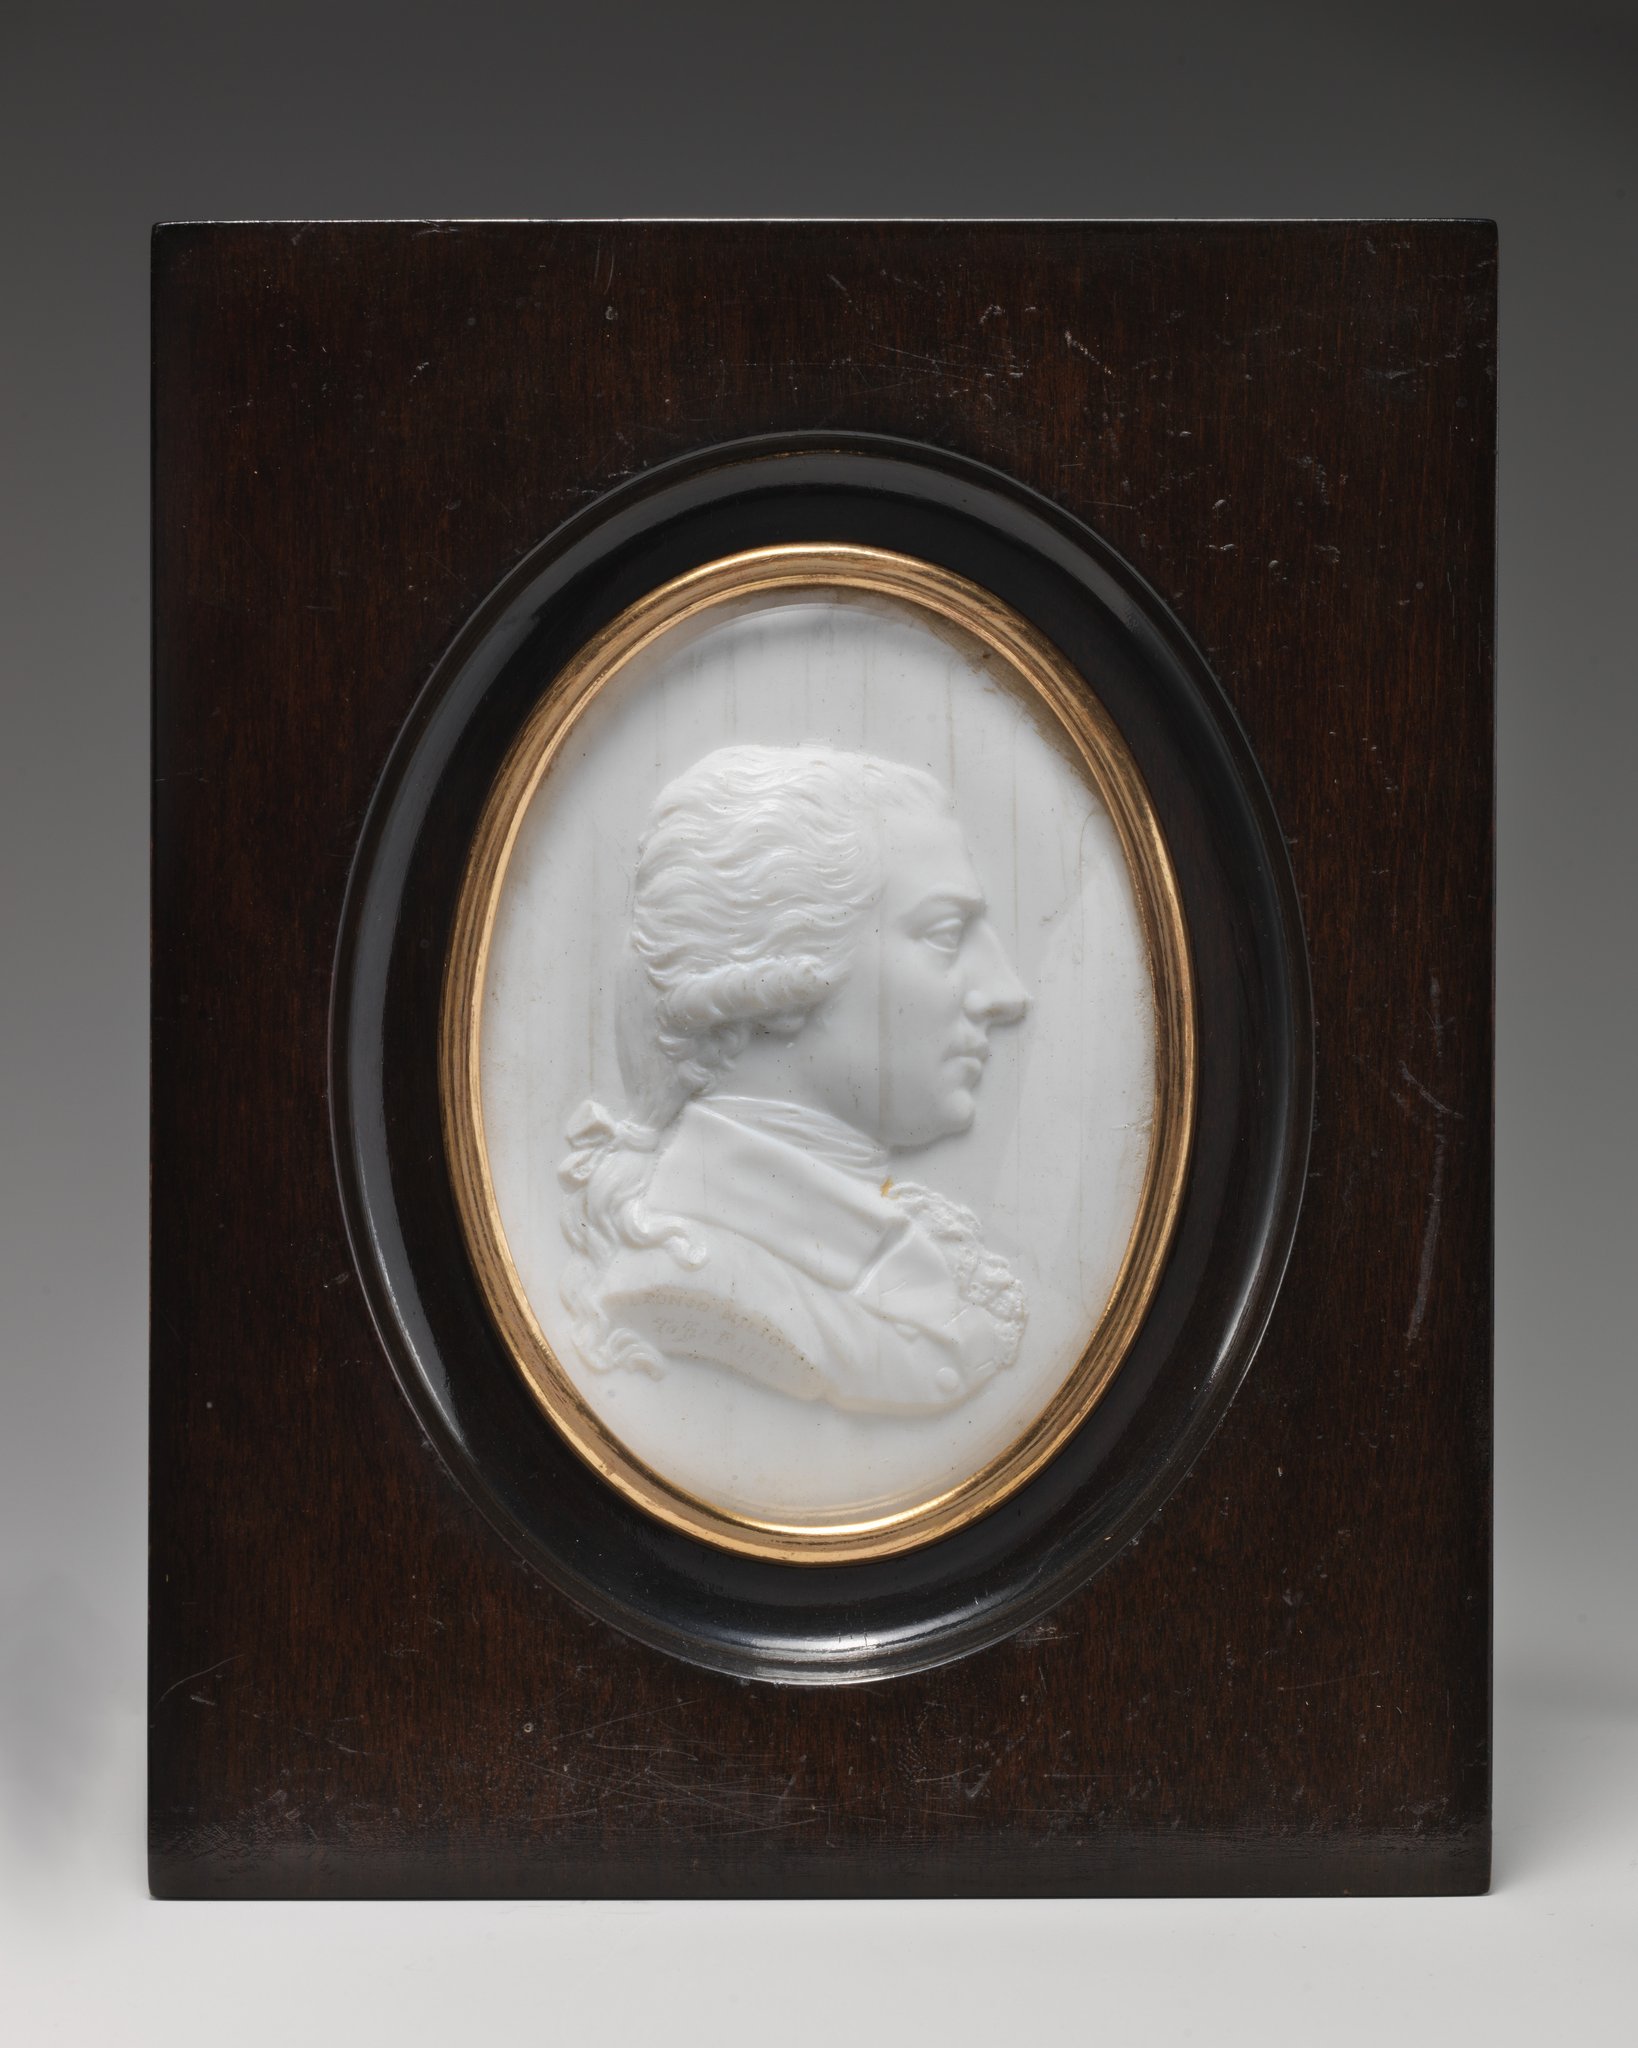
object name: medallion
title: Alfonso Miliotty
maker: james tassie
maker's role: artist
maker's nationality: british, scottish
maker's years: 1735-1799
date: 1784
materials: glass, paste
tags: men,profiles